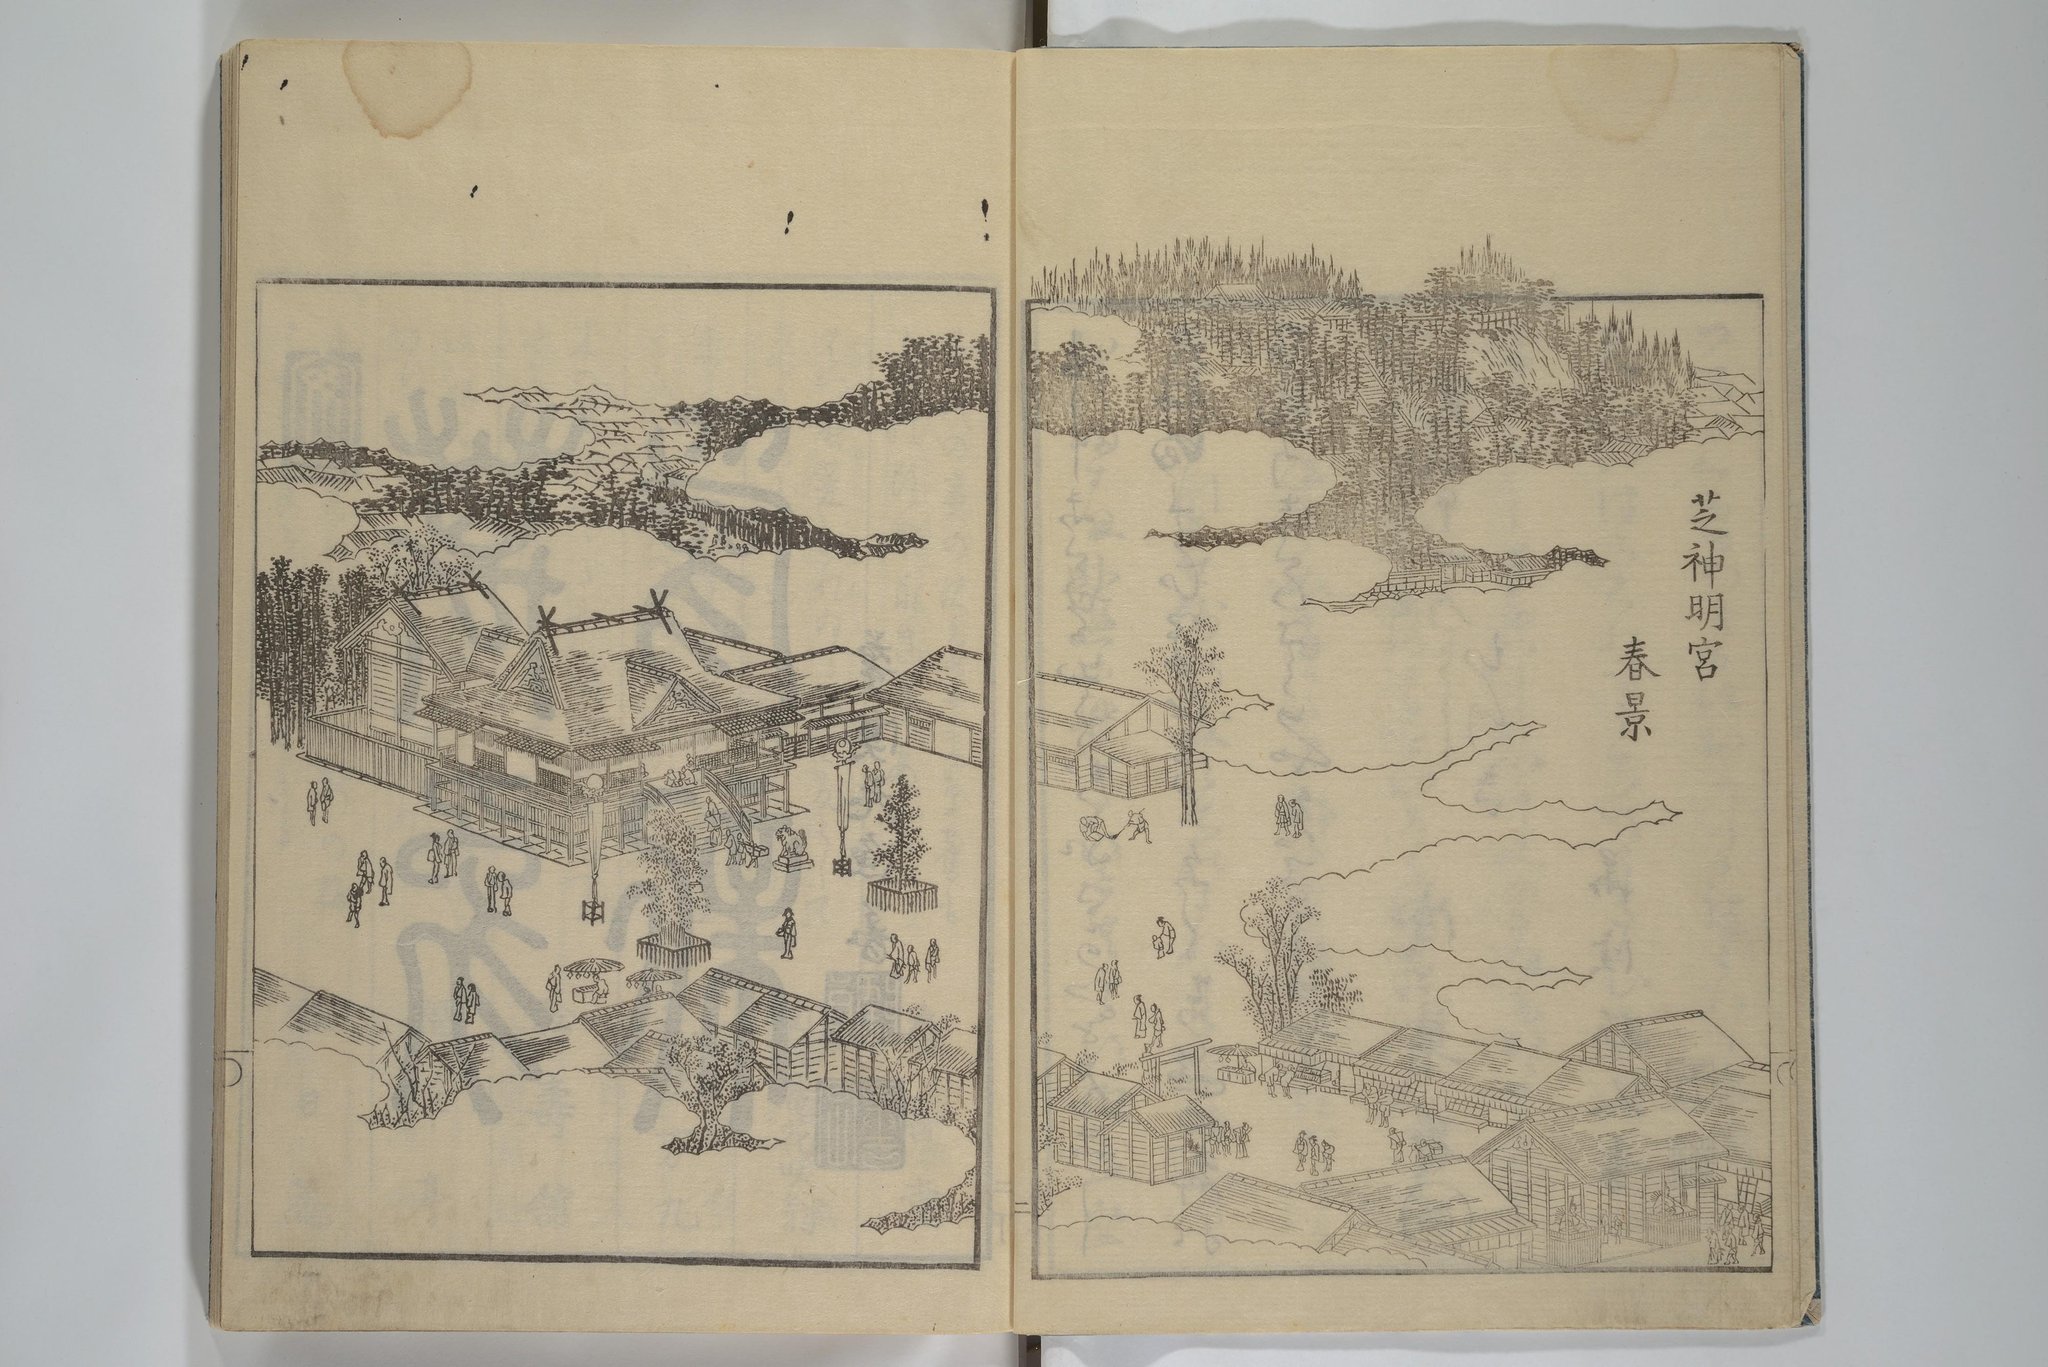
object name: illustrated book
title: Picture Book of the Pleasures of the East (Ehon azuma asobi) 画本東都遊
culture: japanese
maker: katsushika hokusai 葛飾北斎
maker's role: artist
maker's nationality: japanese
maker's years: 1760-1849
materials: ink, paper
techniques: woodblock print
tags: houses,landscapes